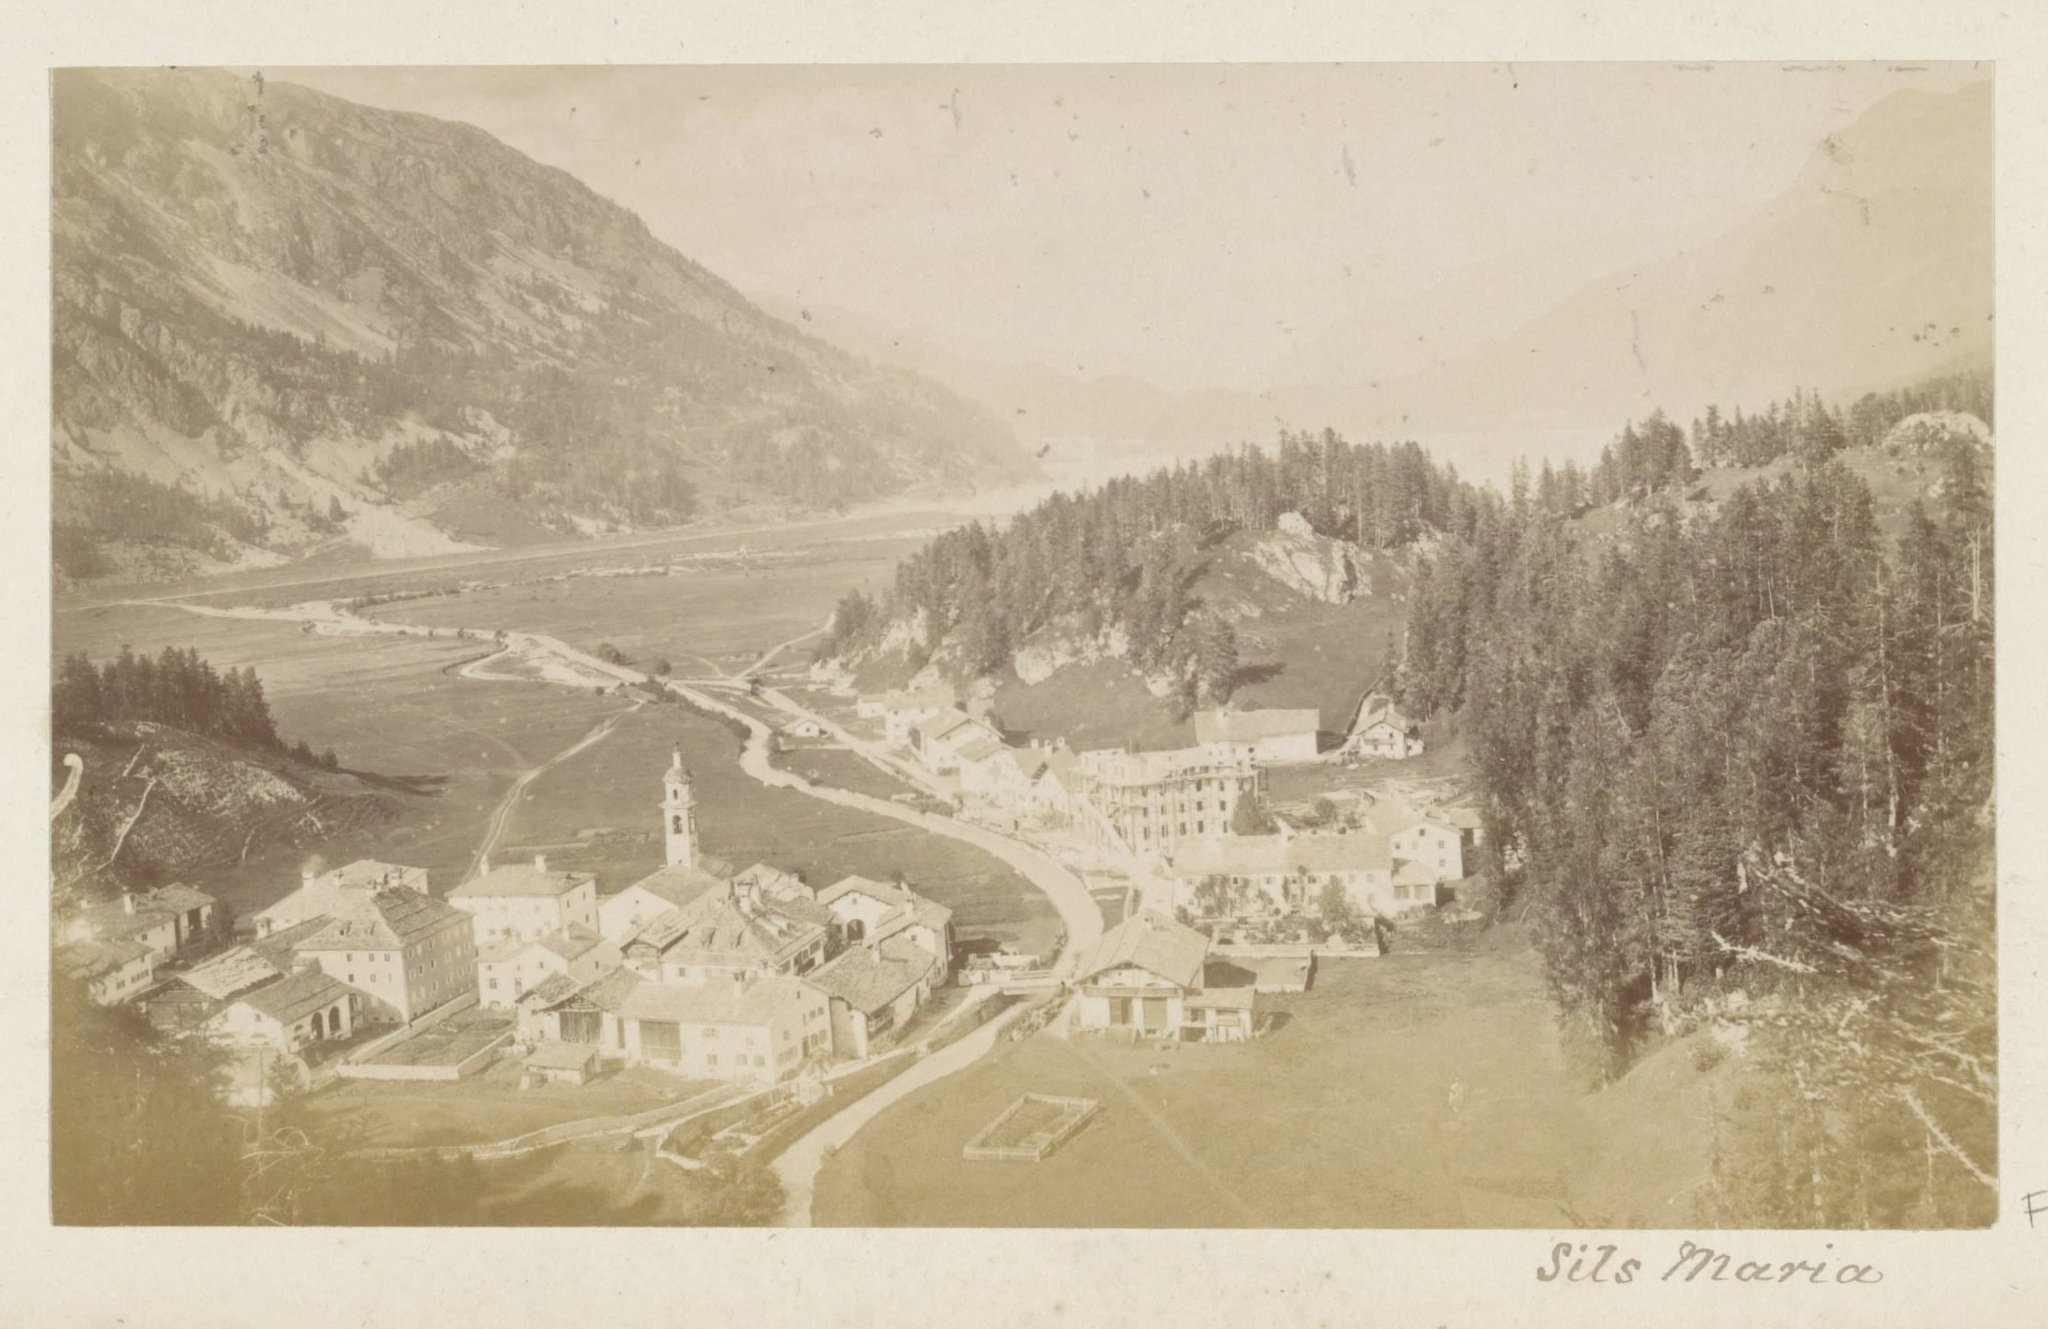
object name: photograph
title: Gezicht op het dorp Sils Maria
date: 1858-1877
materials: paper, photographic support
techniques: albumen print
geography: sils maria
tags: prospect of village, silhouette of village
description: Onderdeel van Reisalbum met foto's van Zwitserland, Oostenrijk, Italië en Duitsland.